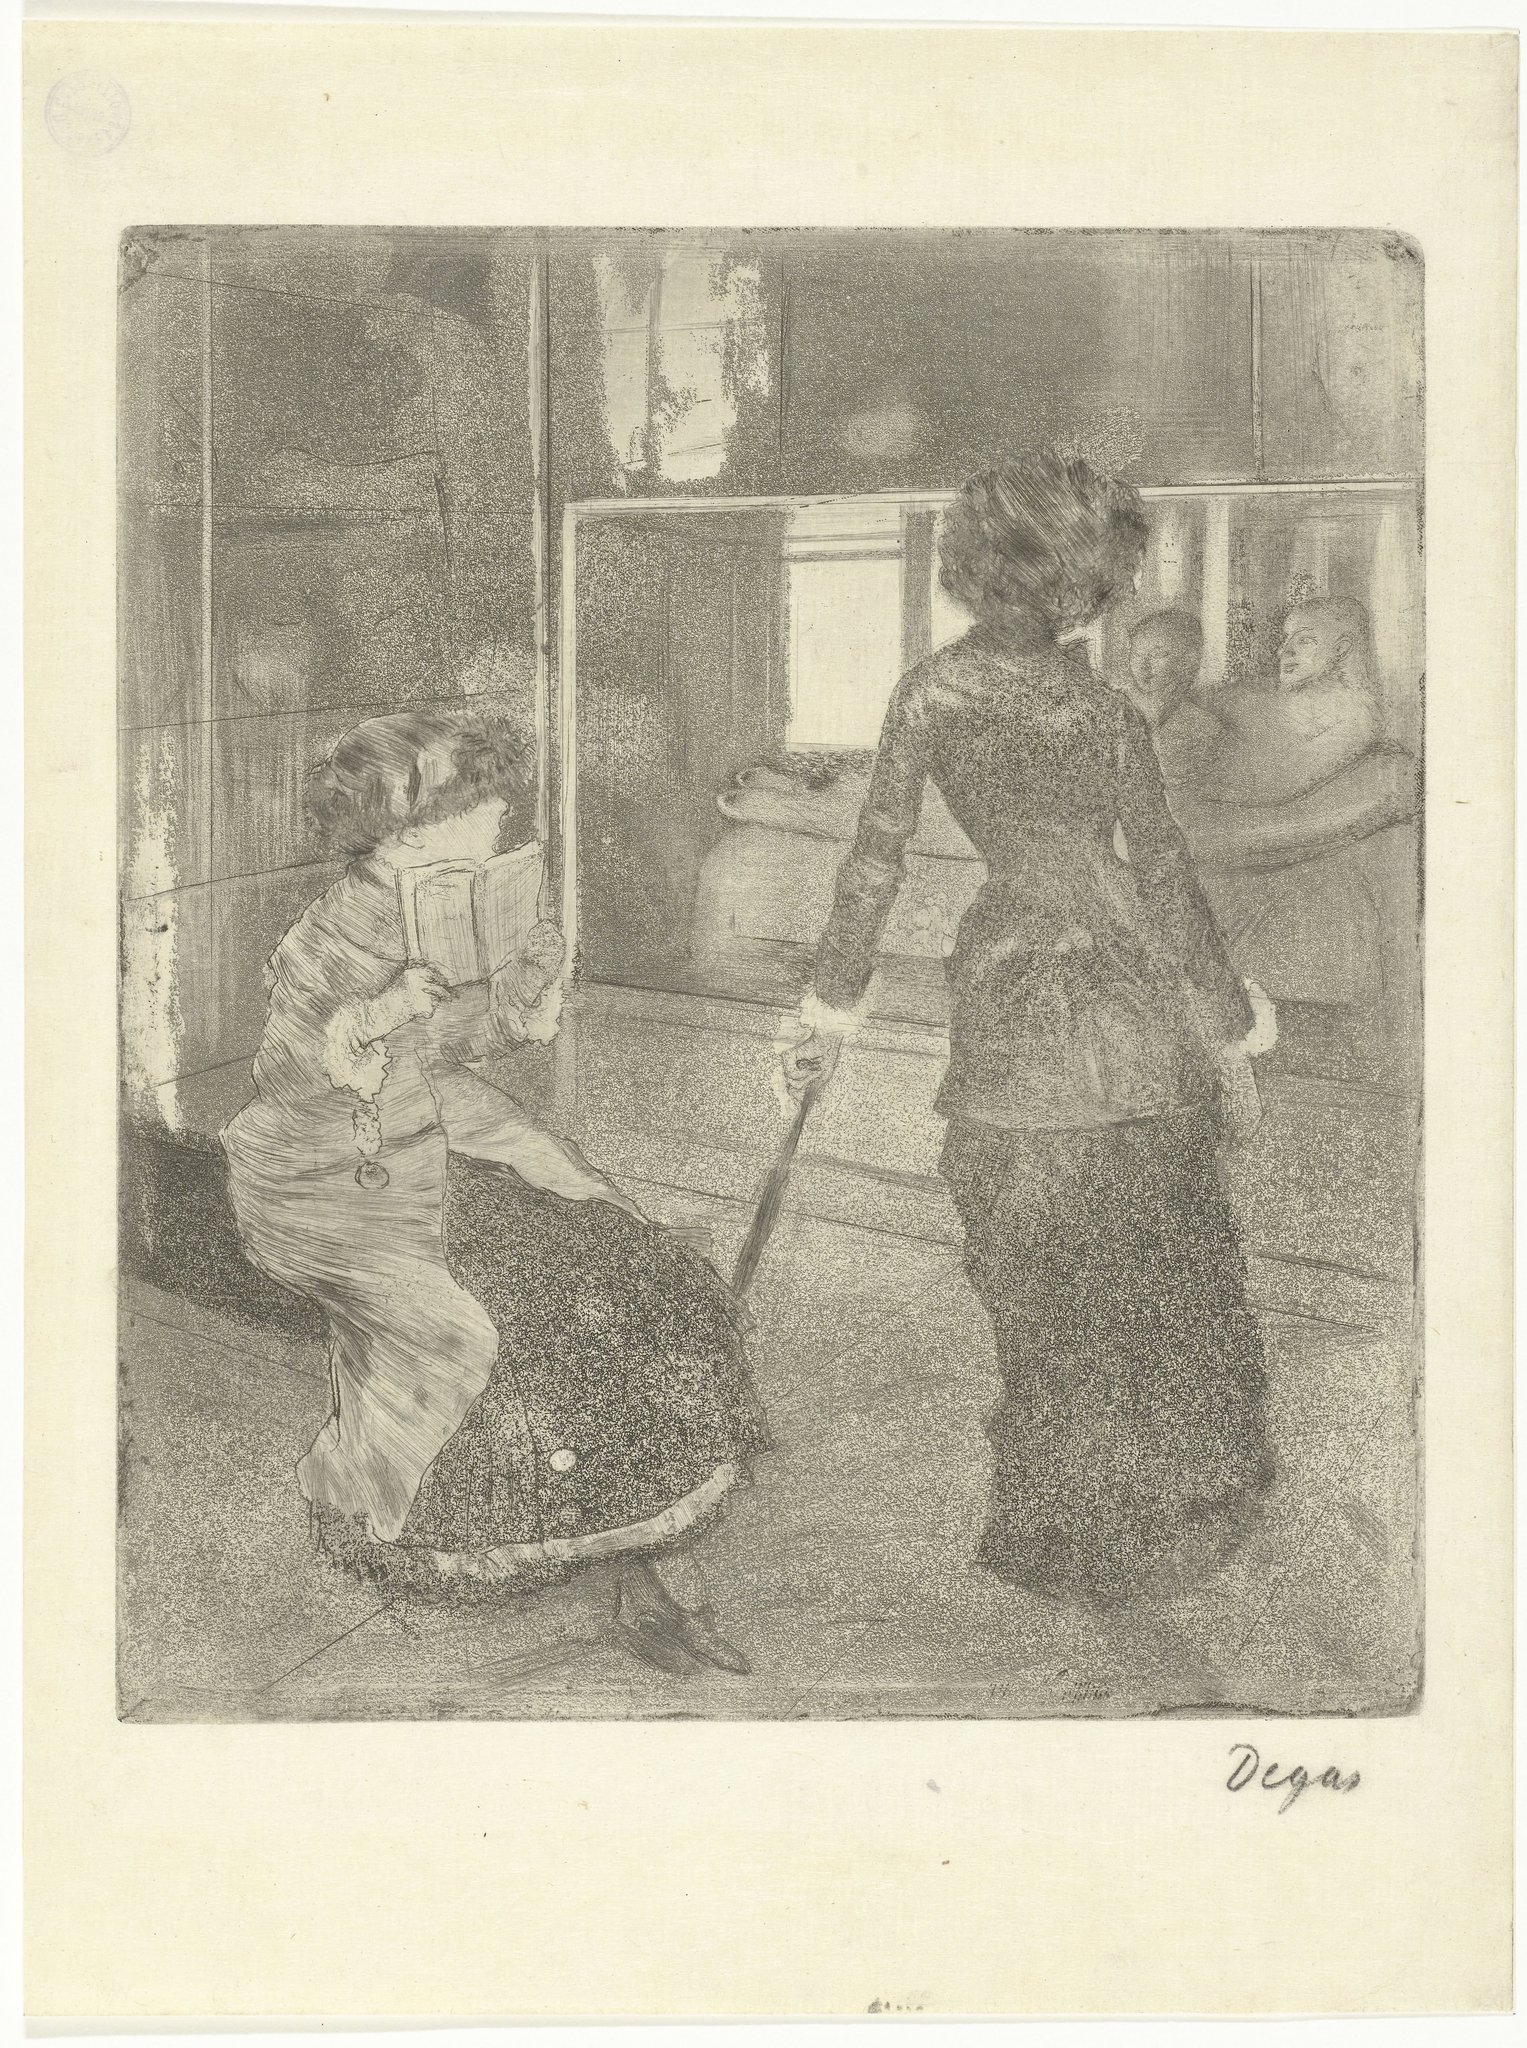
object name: print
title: Mary Cassatt in het Louvre bij de gallerij met Etruskische kunst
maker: edgar degas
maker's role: draughtsman, painter, print maker, sculptor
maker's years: 1834-1917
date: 1879-1880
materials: paper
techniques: aquatint, drypoint, etching, soft ground etching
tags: print maker, mary cassatt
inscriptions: stamp:, collector's mark: Lugt 2228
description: Mary Cassatt staat elegant leunend op een paraplu te kijken naar een Etruskisch grafbeeld in een vitrine in het Louvre. Naast haar zit een vrouw met een boek.